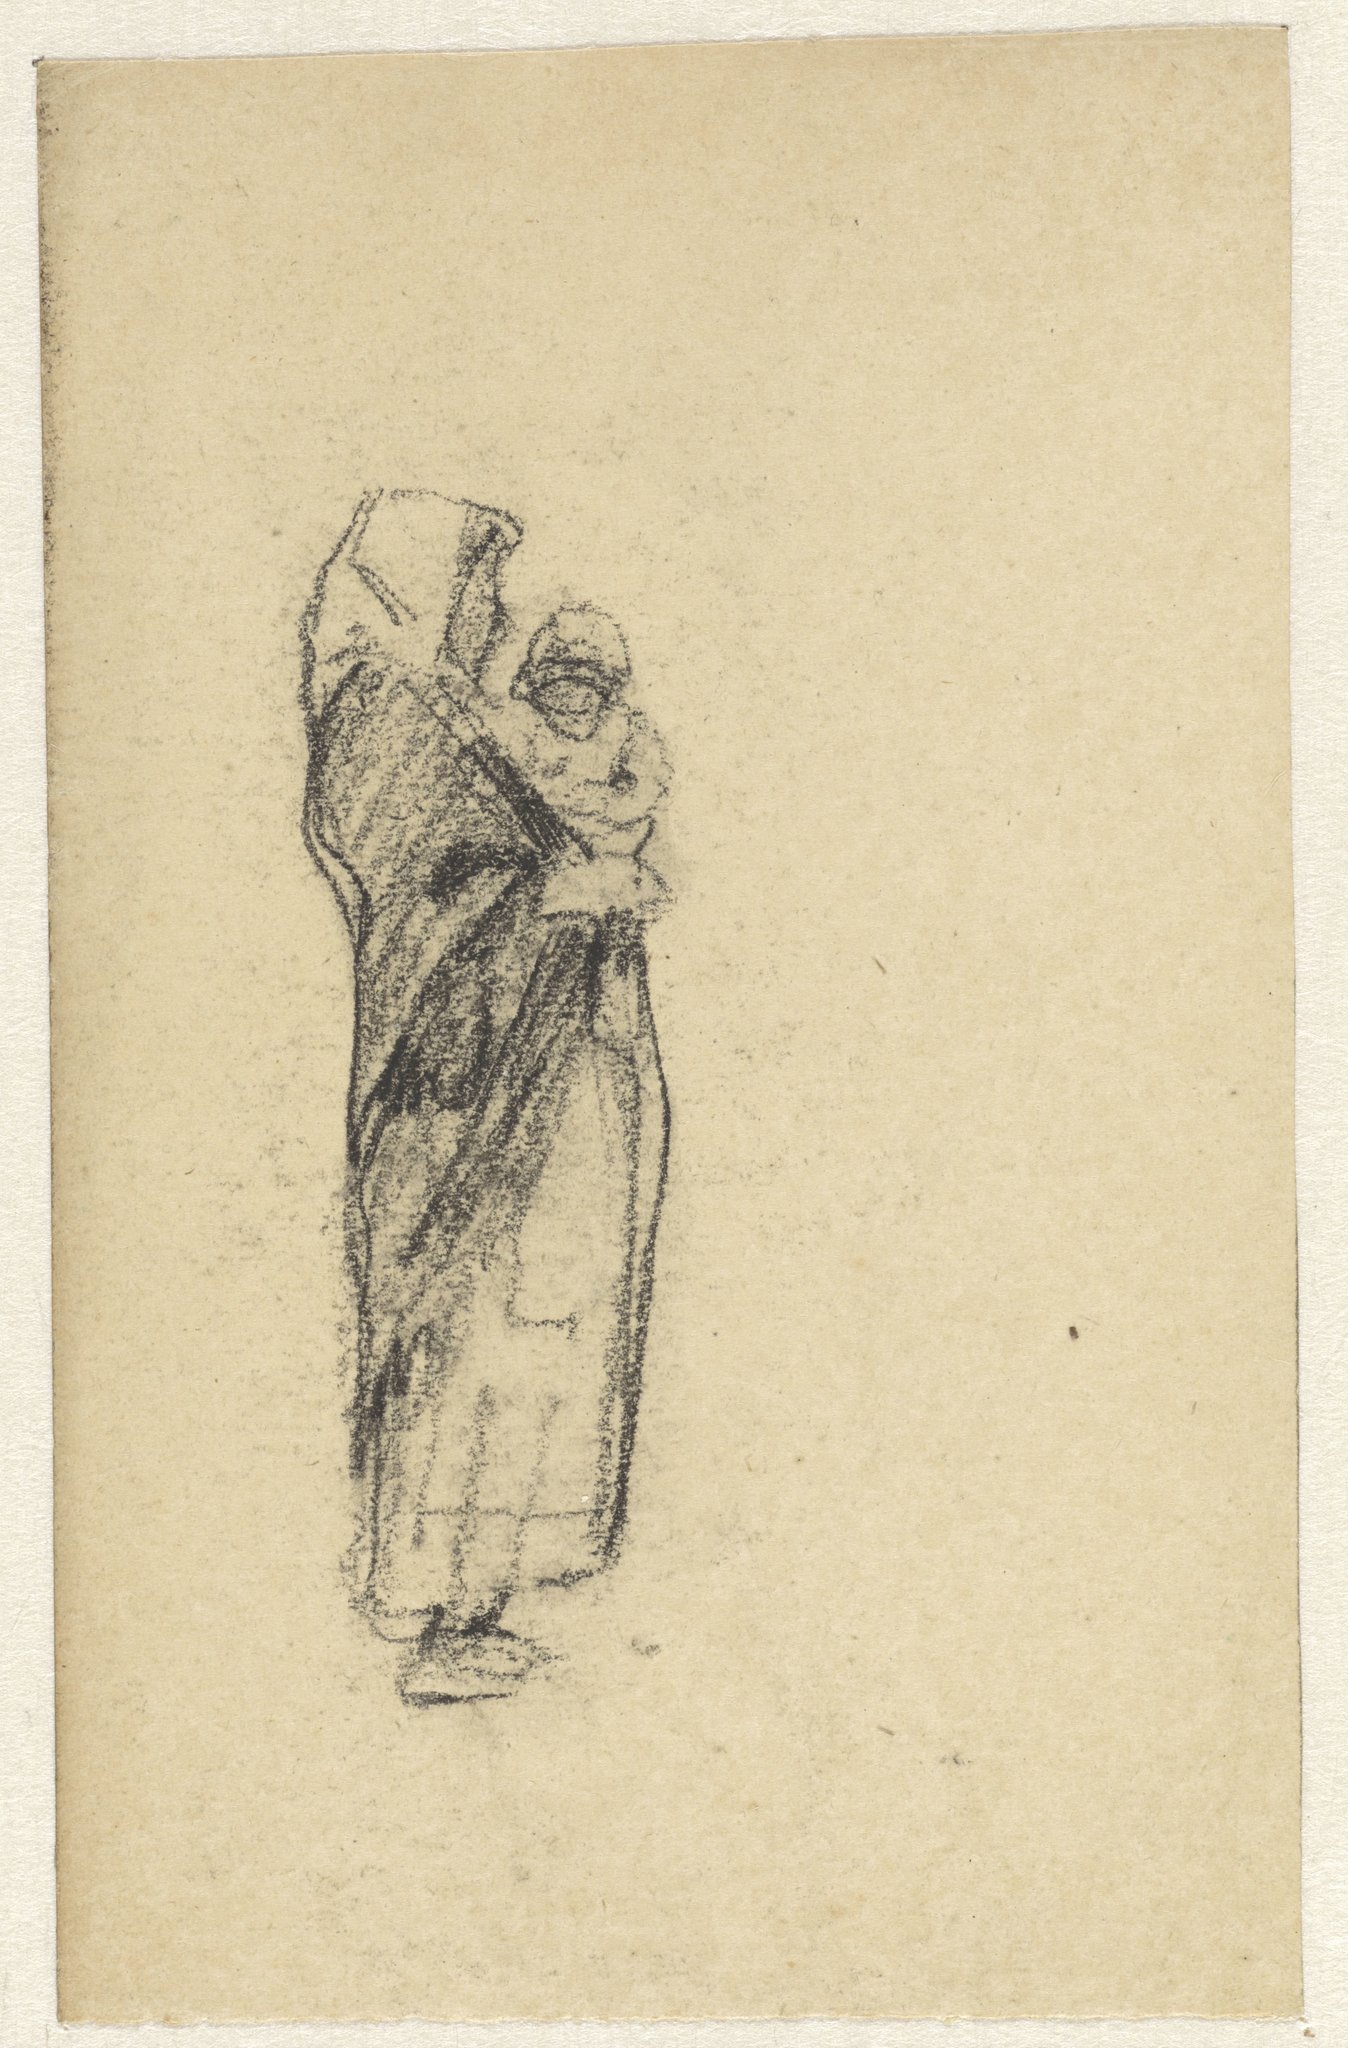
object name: drawing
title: Staande vrouw met kind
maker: jac van looij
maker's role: draughtsman, painter, print maker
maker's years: 1855-1930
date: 1865-1930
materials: chalk, paper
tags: mother and baby or young child